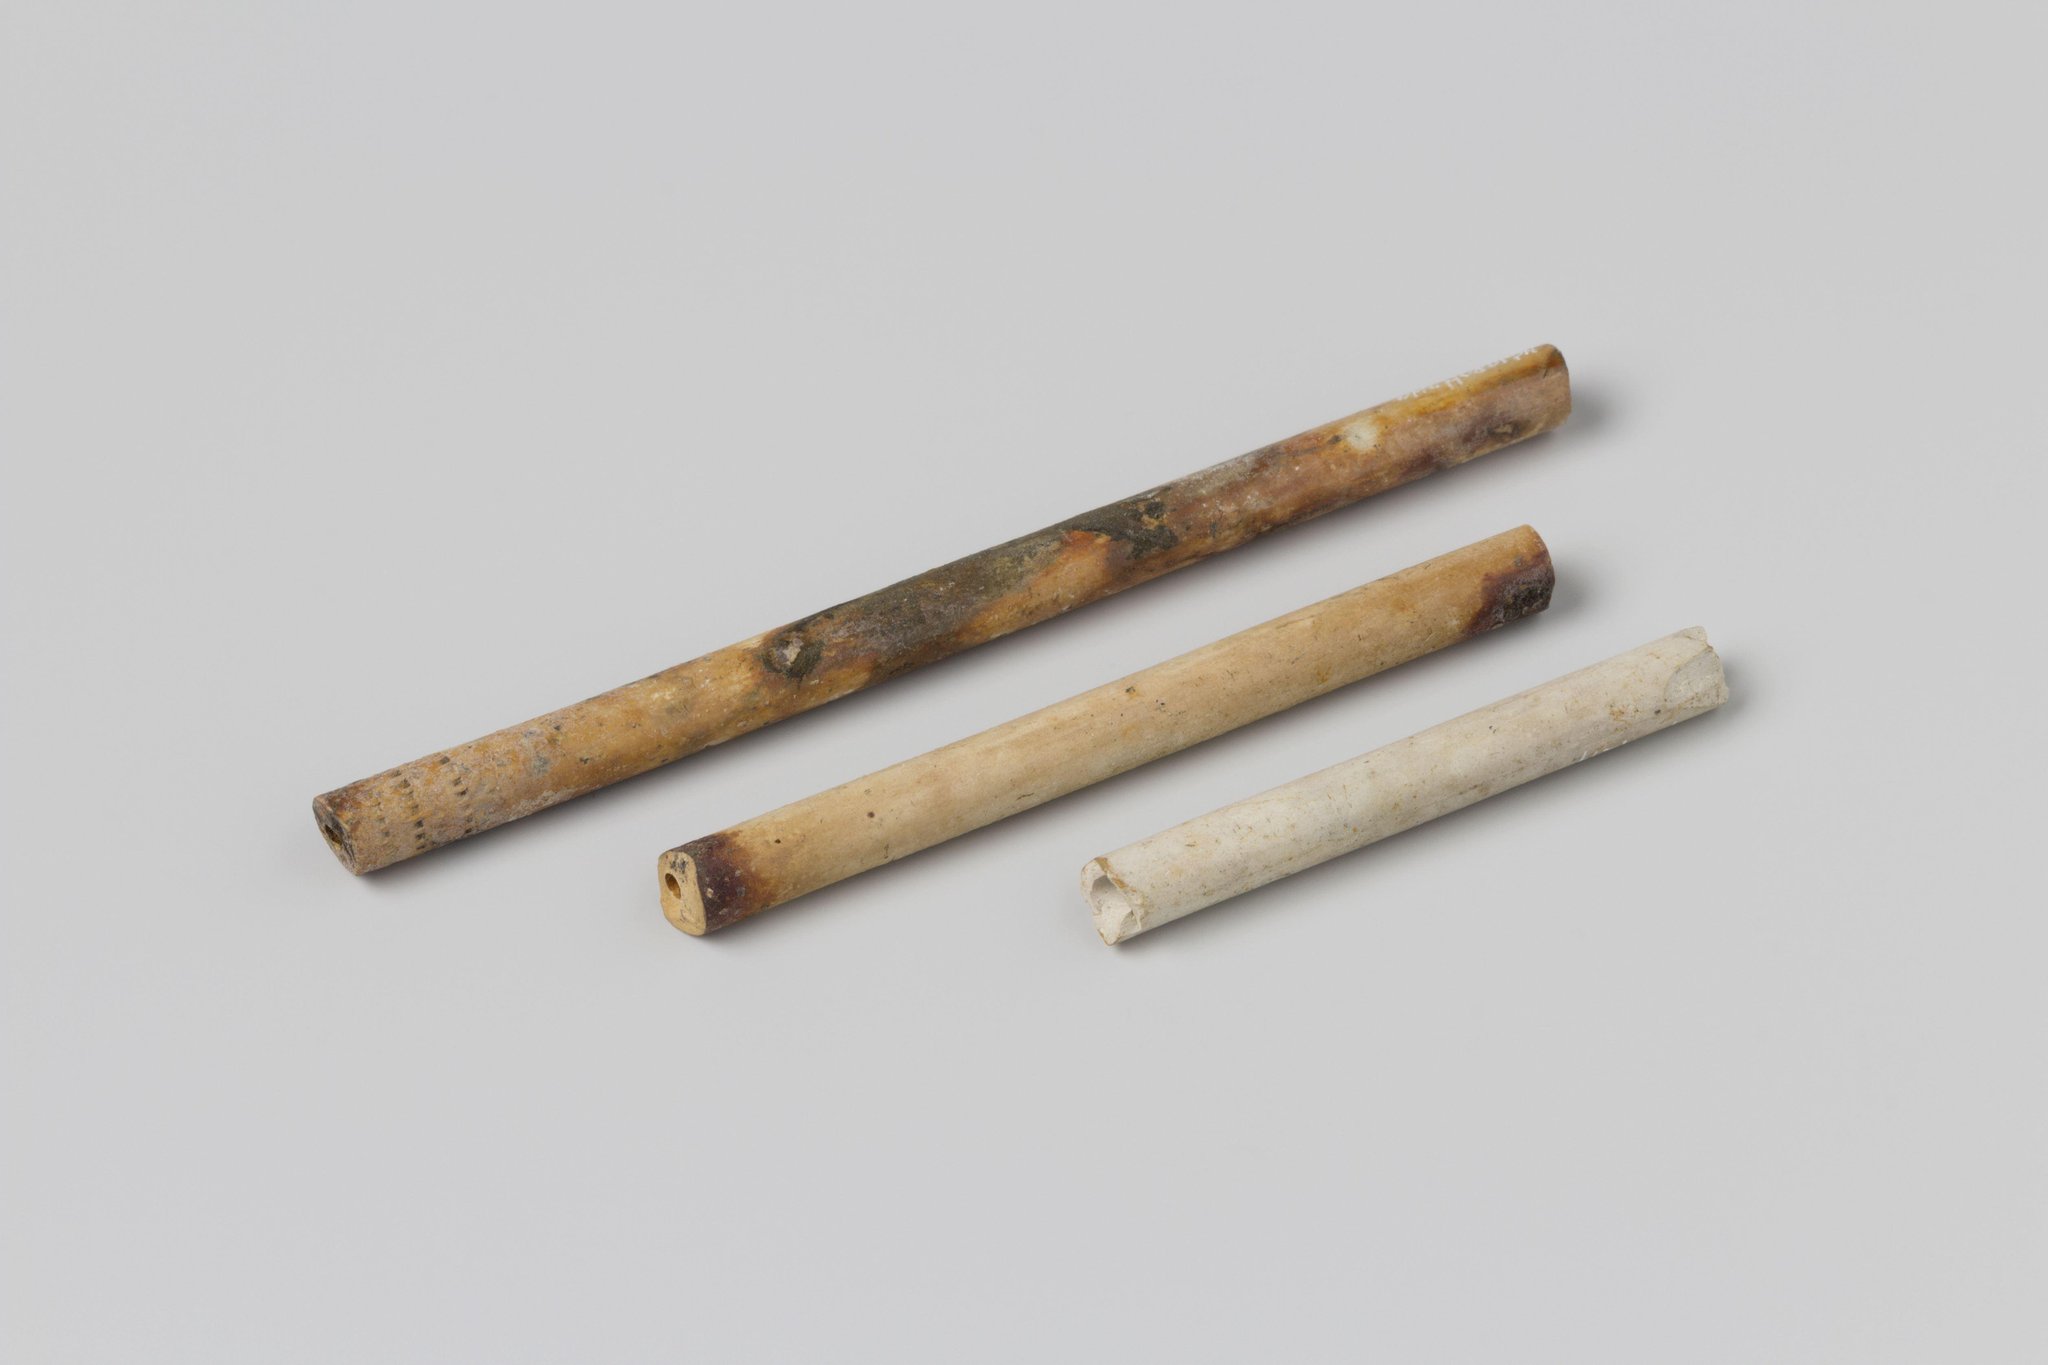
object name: pipe stem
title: Fragmenten pijpenstelen uit het wrak van de Oost-Indiëvaarder Hollandia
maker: Anonymous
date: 1700-1743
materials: clay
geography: netherlands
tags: verenigde oostindische compagnie, hollandia (schip), annet